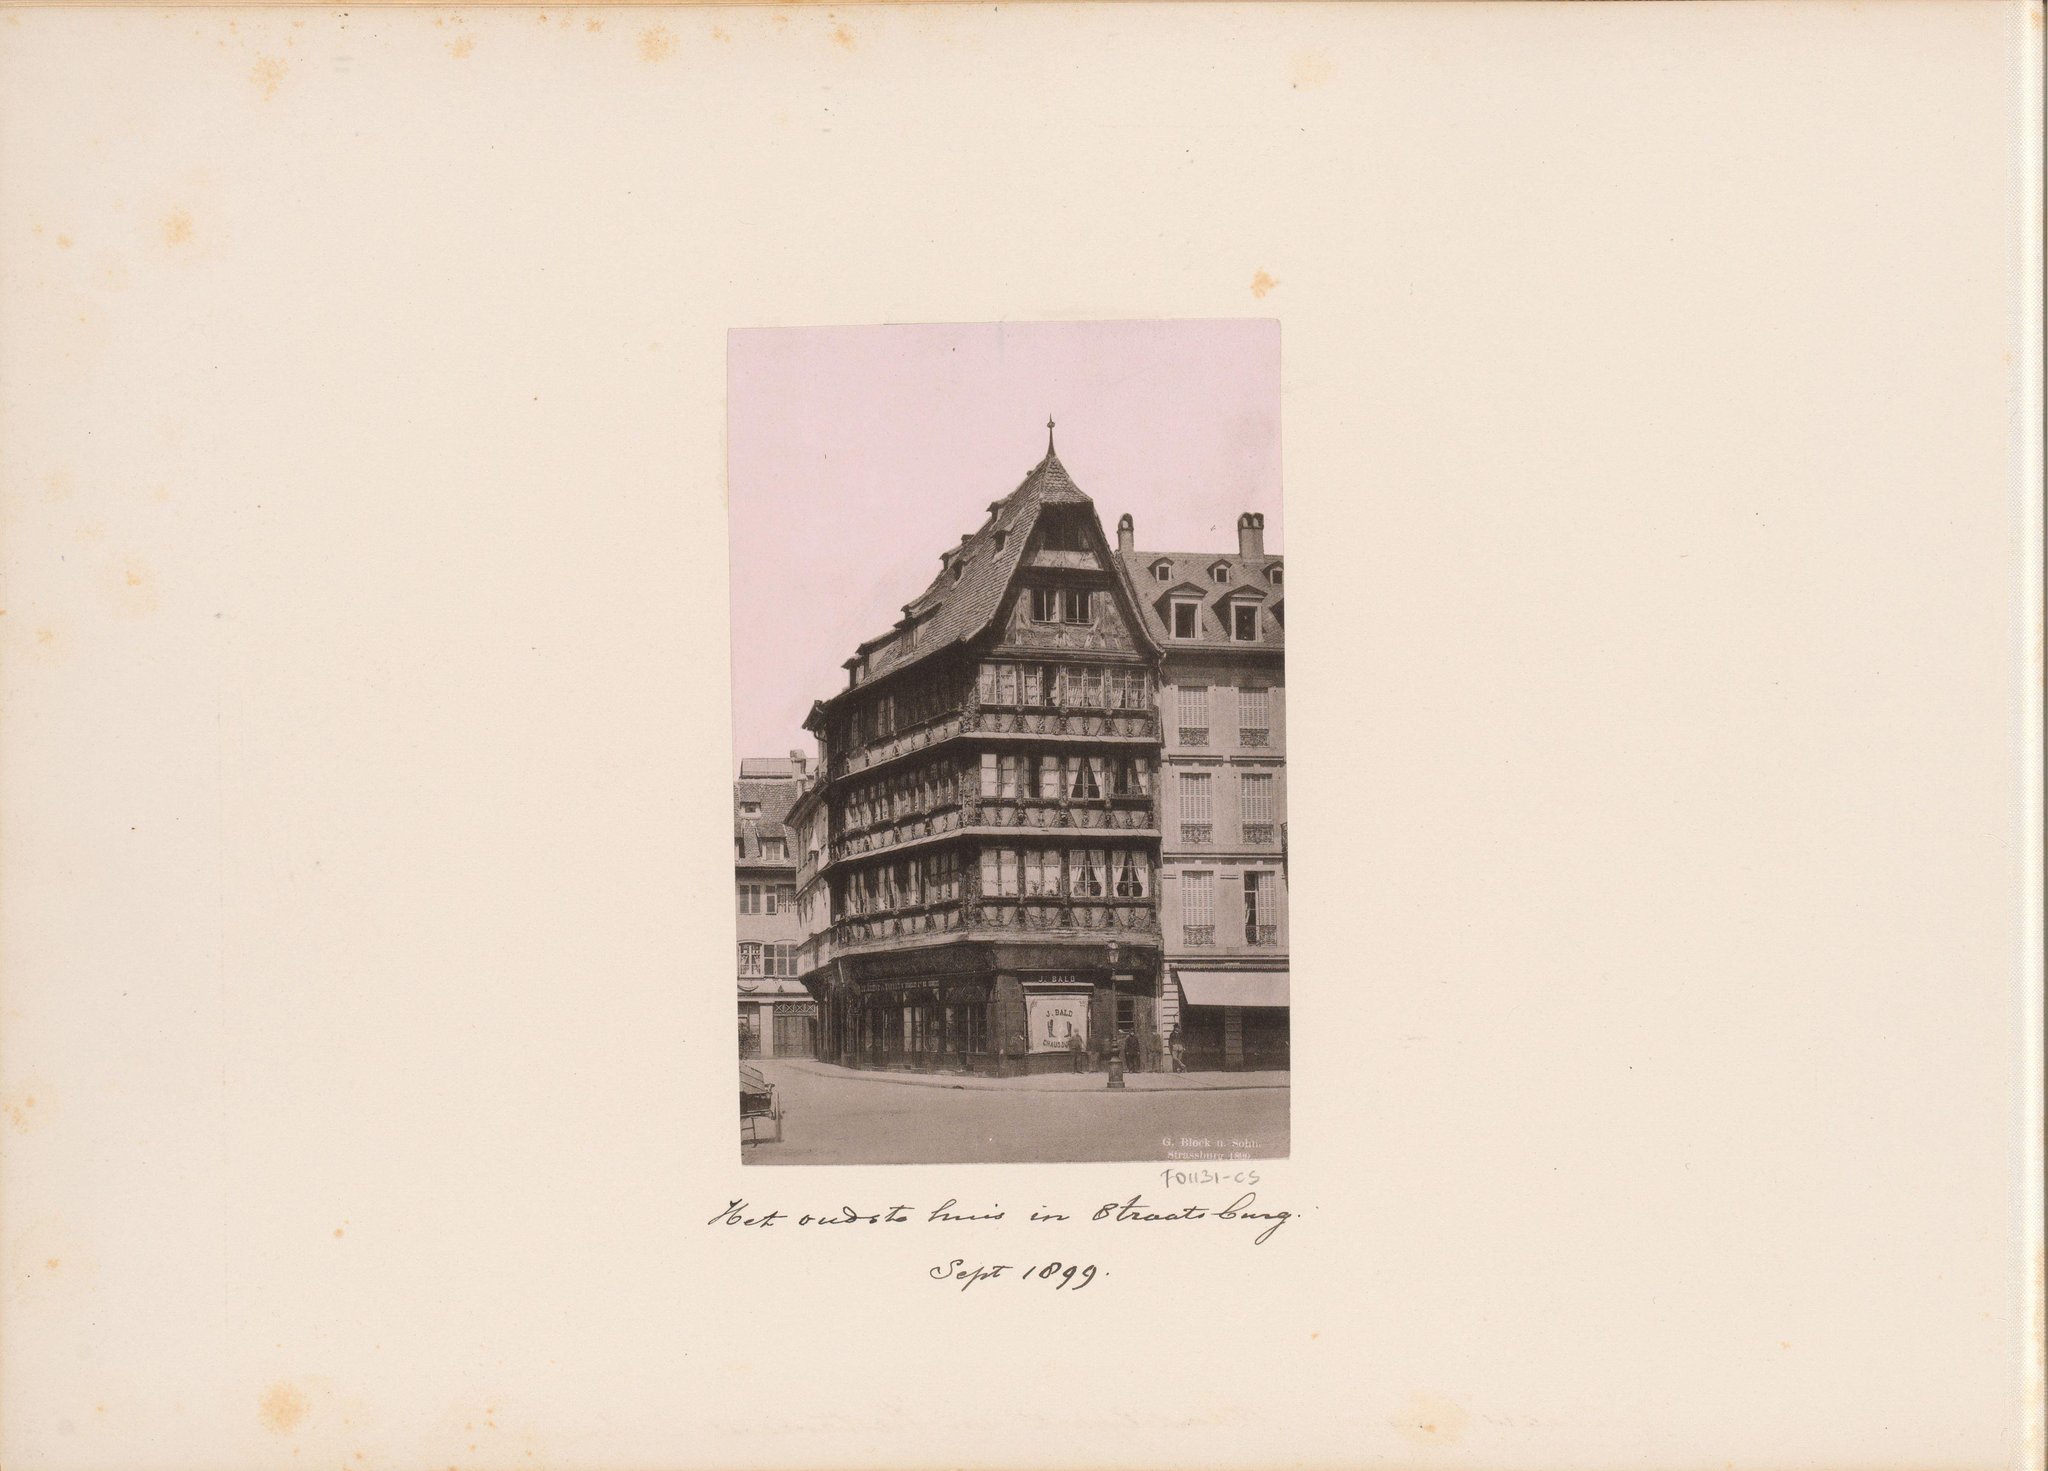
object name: photograph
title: Haus Kammerzell in Straatsburg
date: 1890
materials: paper, photographic support, ink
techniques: photograph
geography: straatsburg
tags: façade (of house or building)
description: Onderdeel van Reisalbum met bezienswaardigheden in Duitsland, Oostenrijk, Zwitserland, Luxemburg en België.